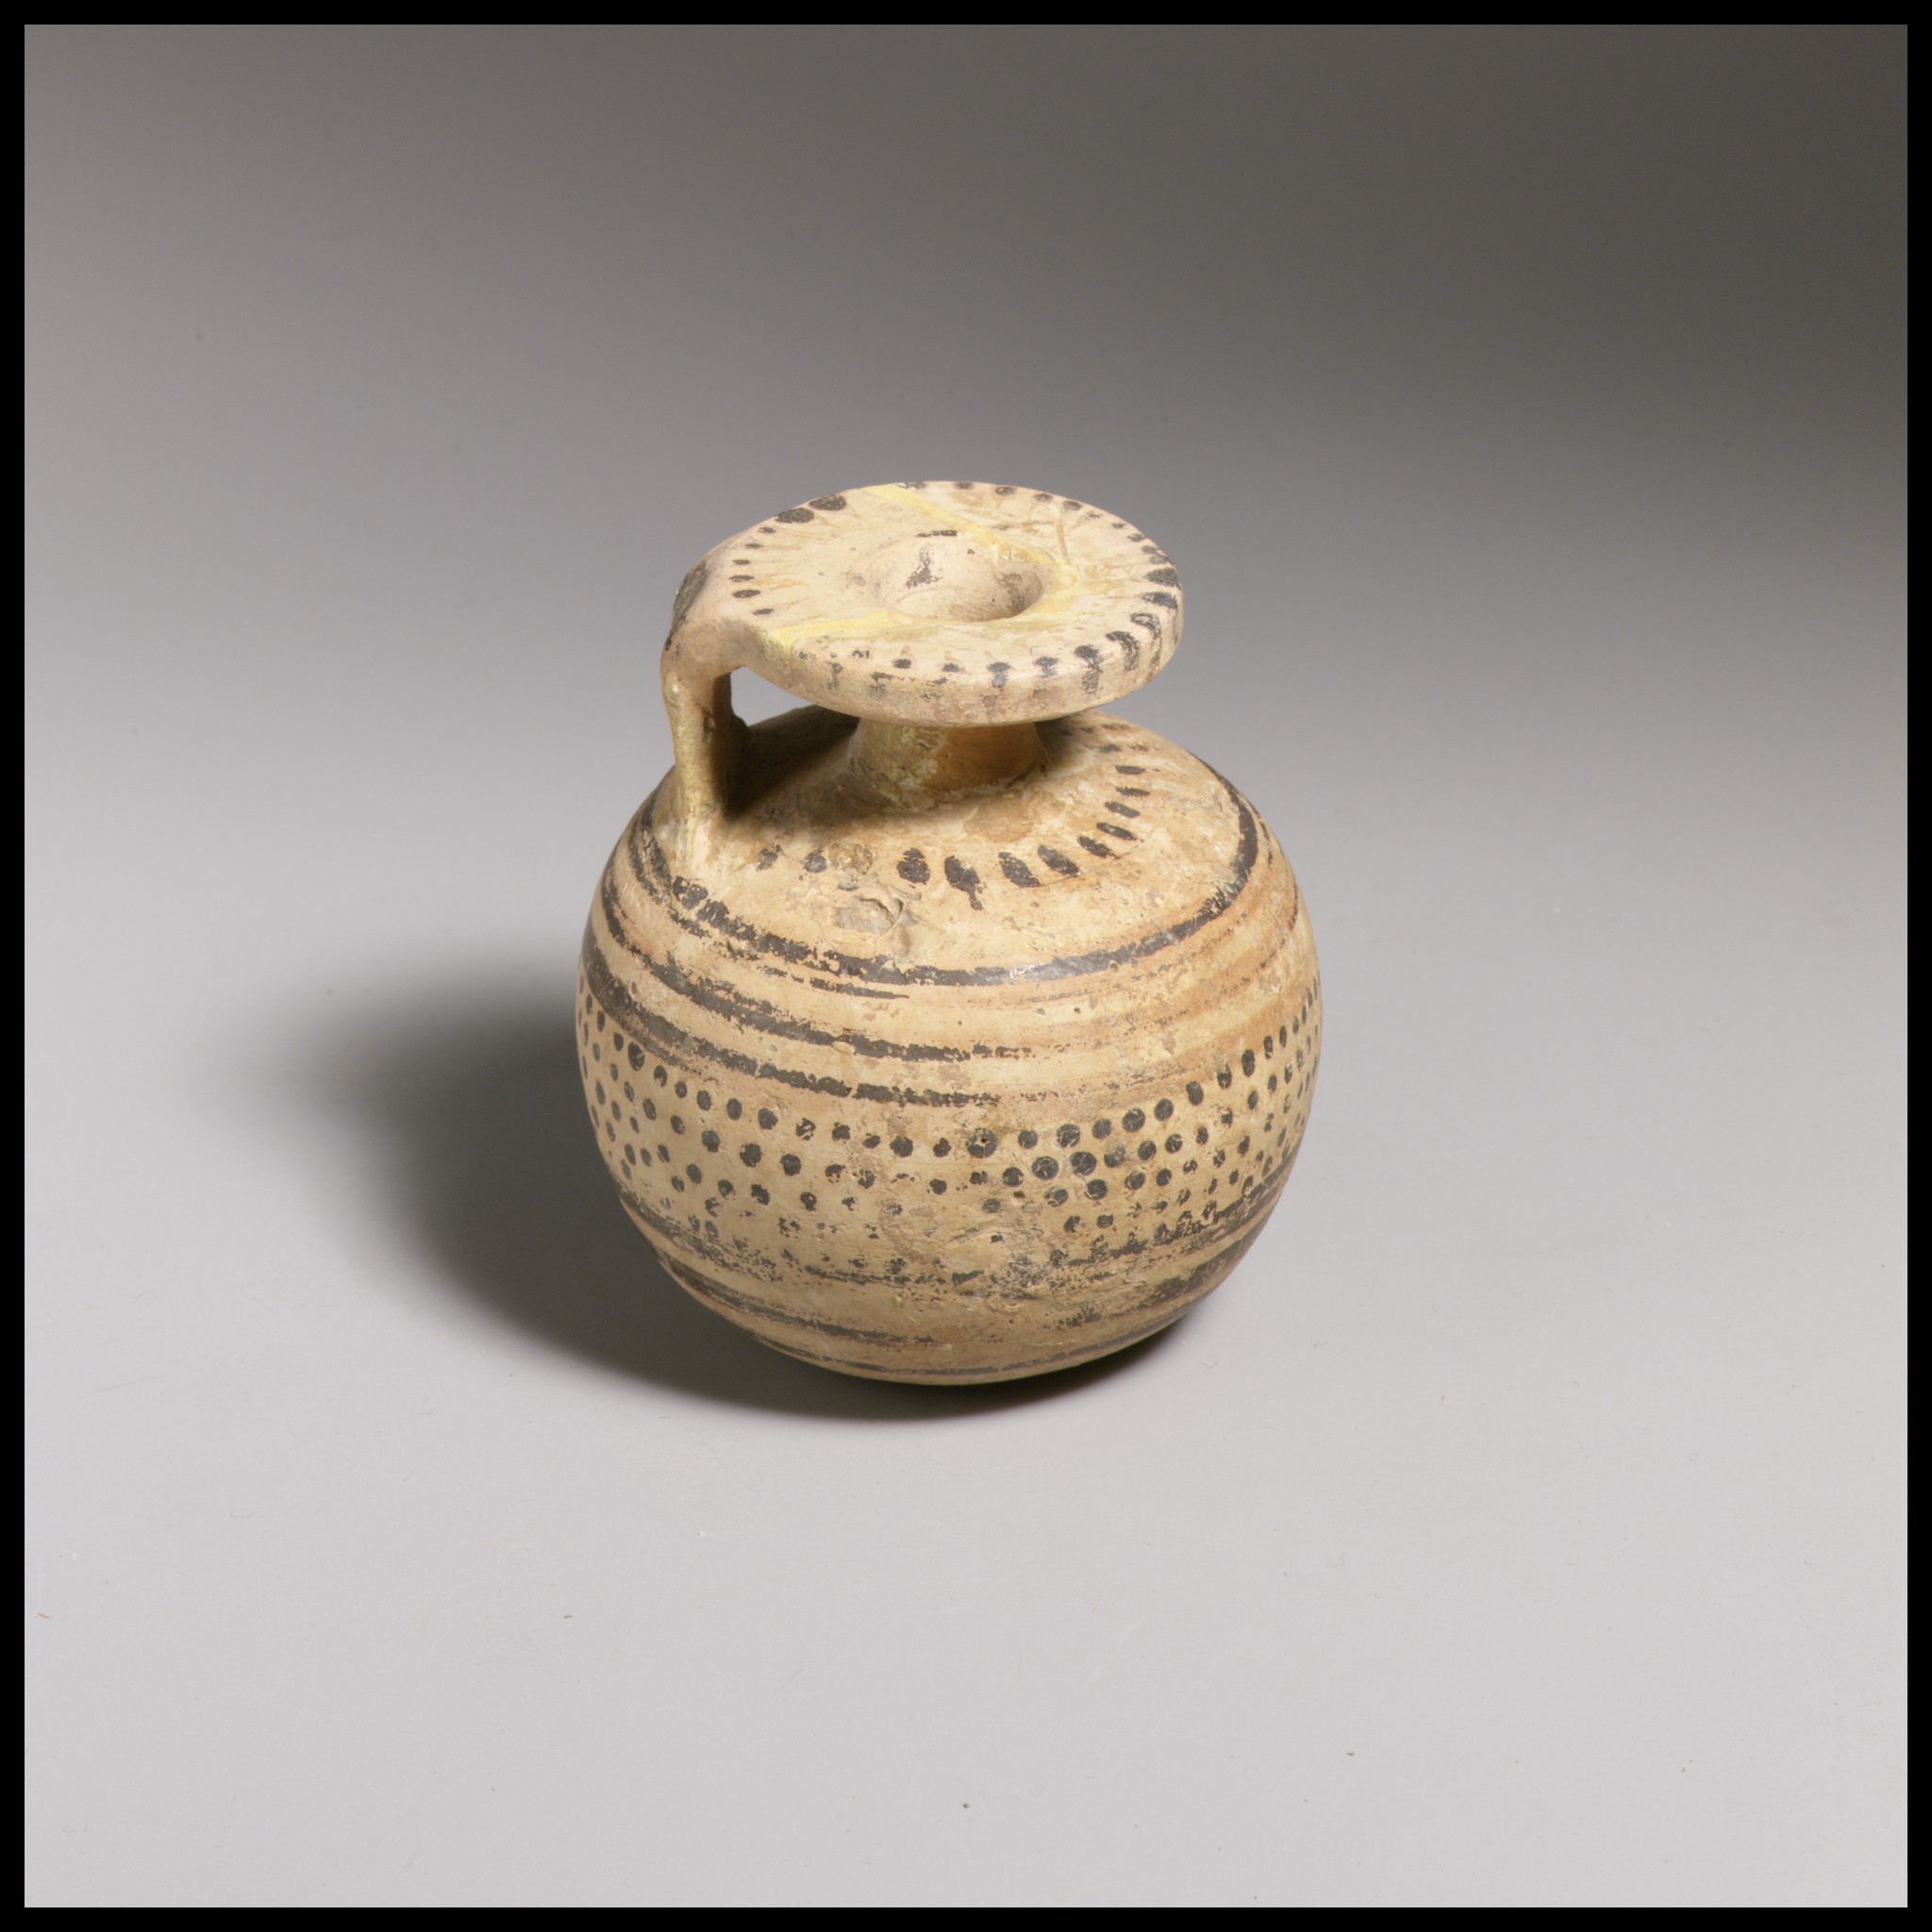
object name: aryballos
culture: etruria or italic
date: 600-501 BCE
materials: terracotta